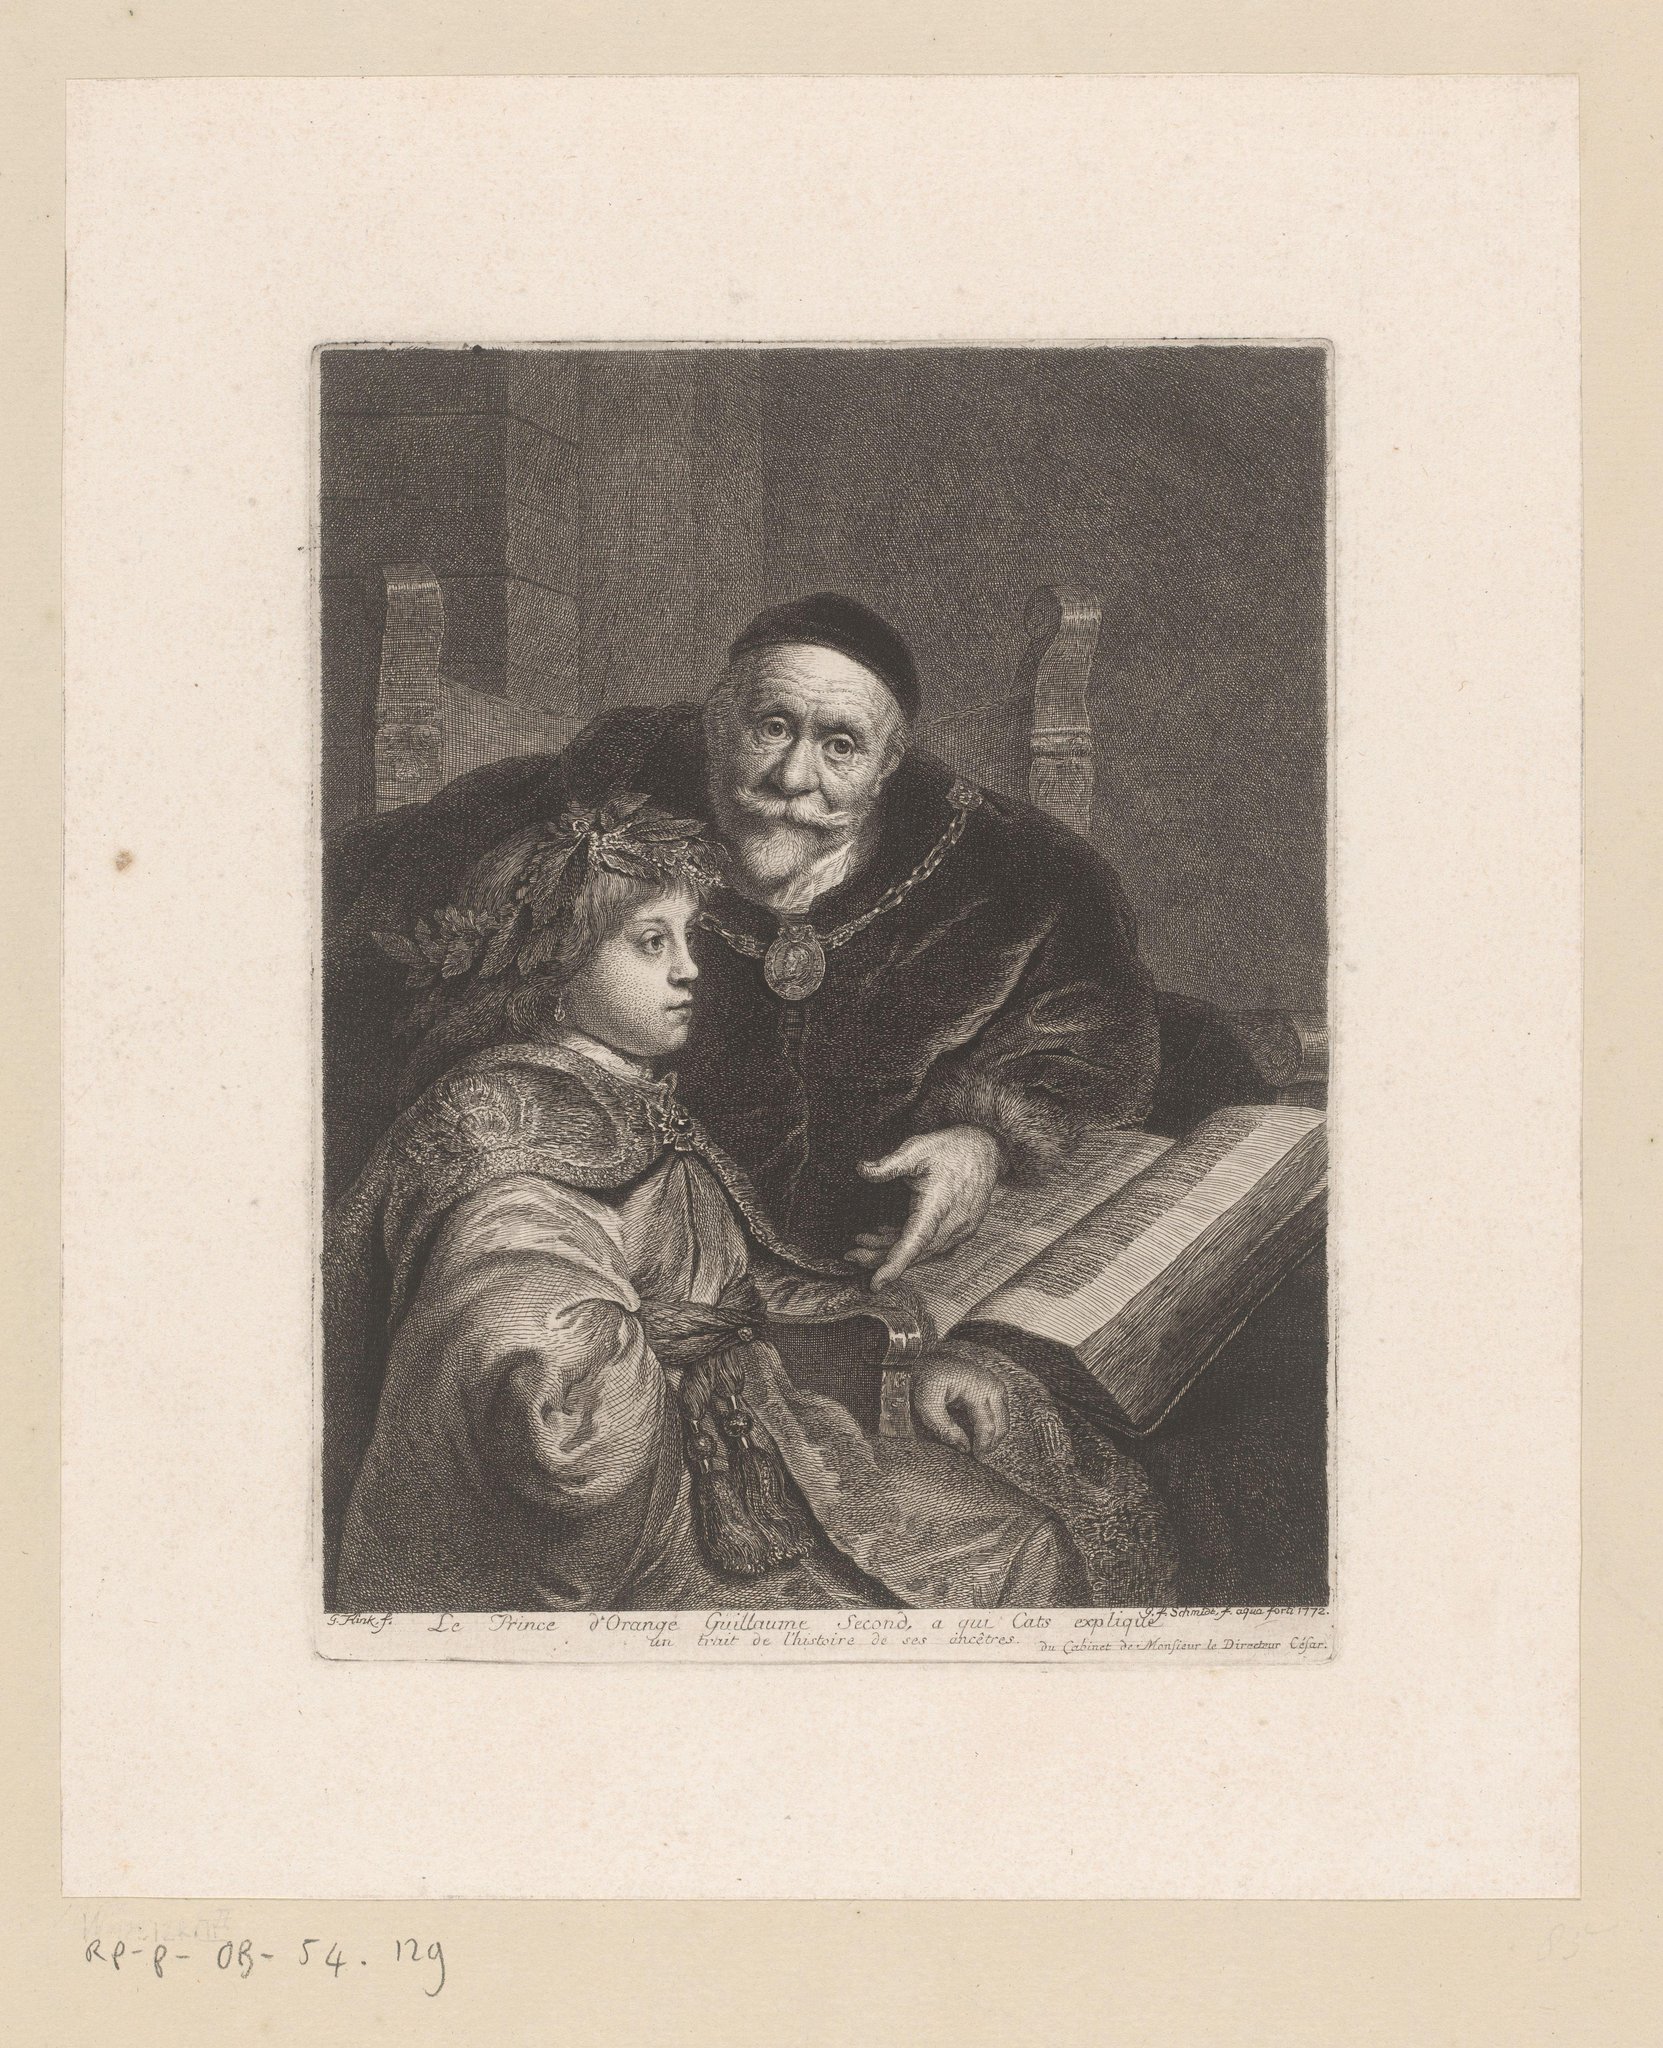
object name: print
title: Portret van Carl Ludwig van de Palts met Wolrad von Plessen in de rol van Alexander de Grote en Aristoteles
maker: georg friedrich schmidt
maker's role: draughtsman, print maker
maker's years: 1712-1775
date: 1772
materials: paper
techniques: etching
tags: leiden, historical persons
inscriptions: collector's mark: Lugt 240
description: Naar een schilderij van Jan Lievens gedateerd 1631, heden in The J. Paul Getty Museum, Los Angeles/Malibu , inv./cat.nr 71PA53.